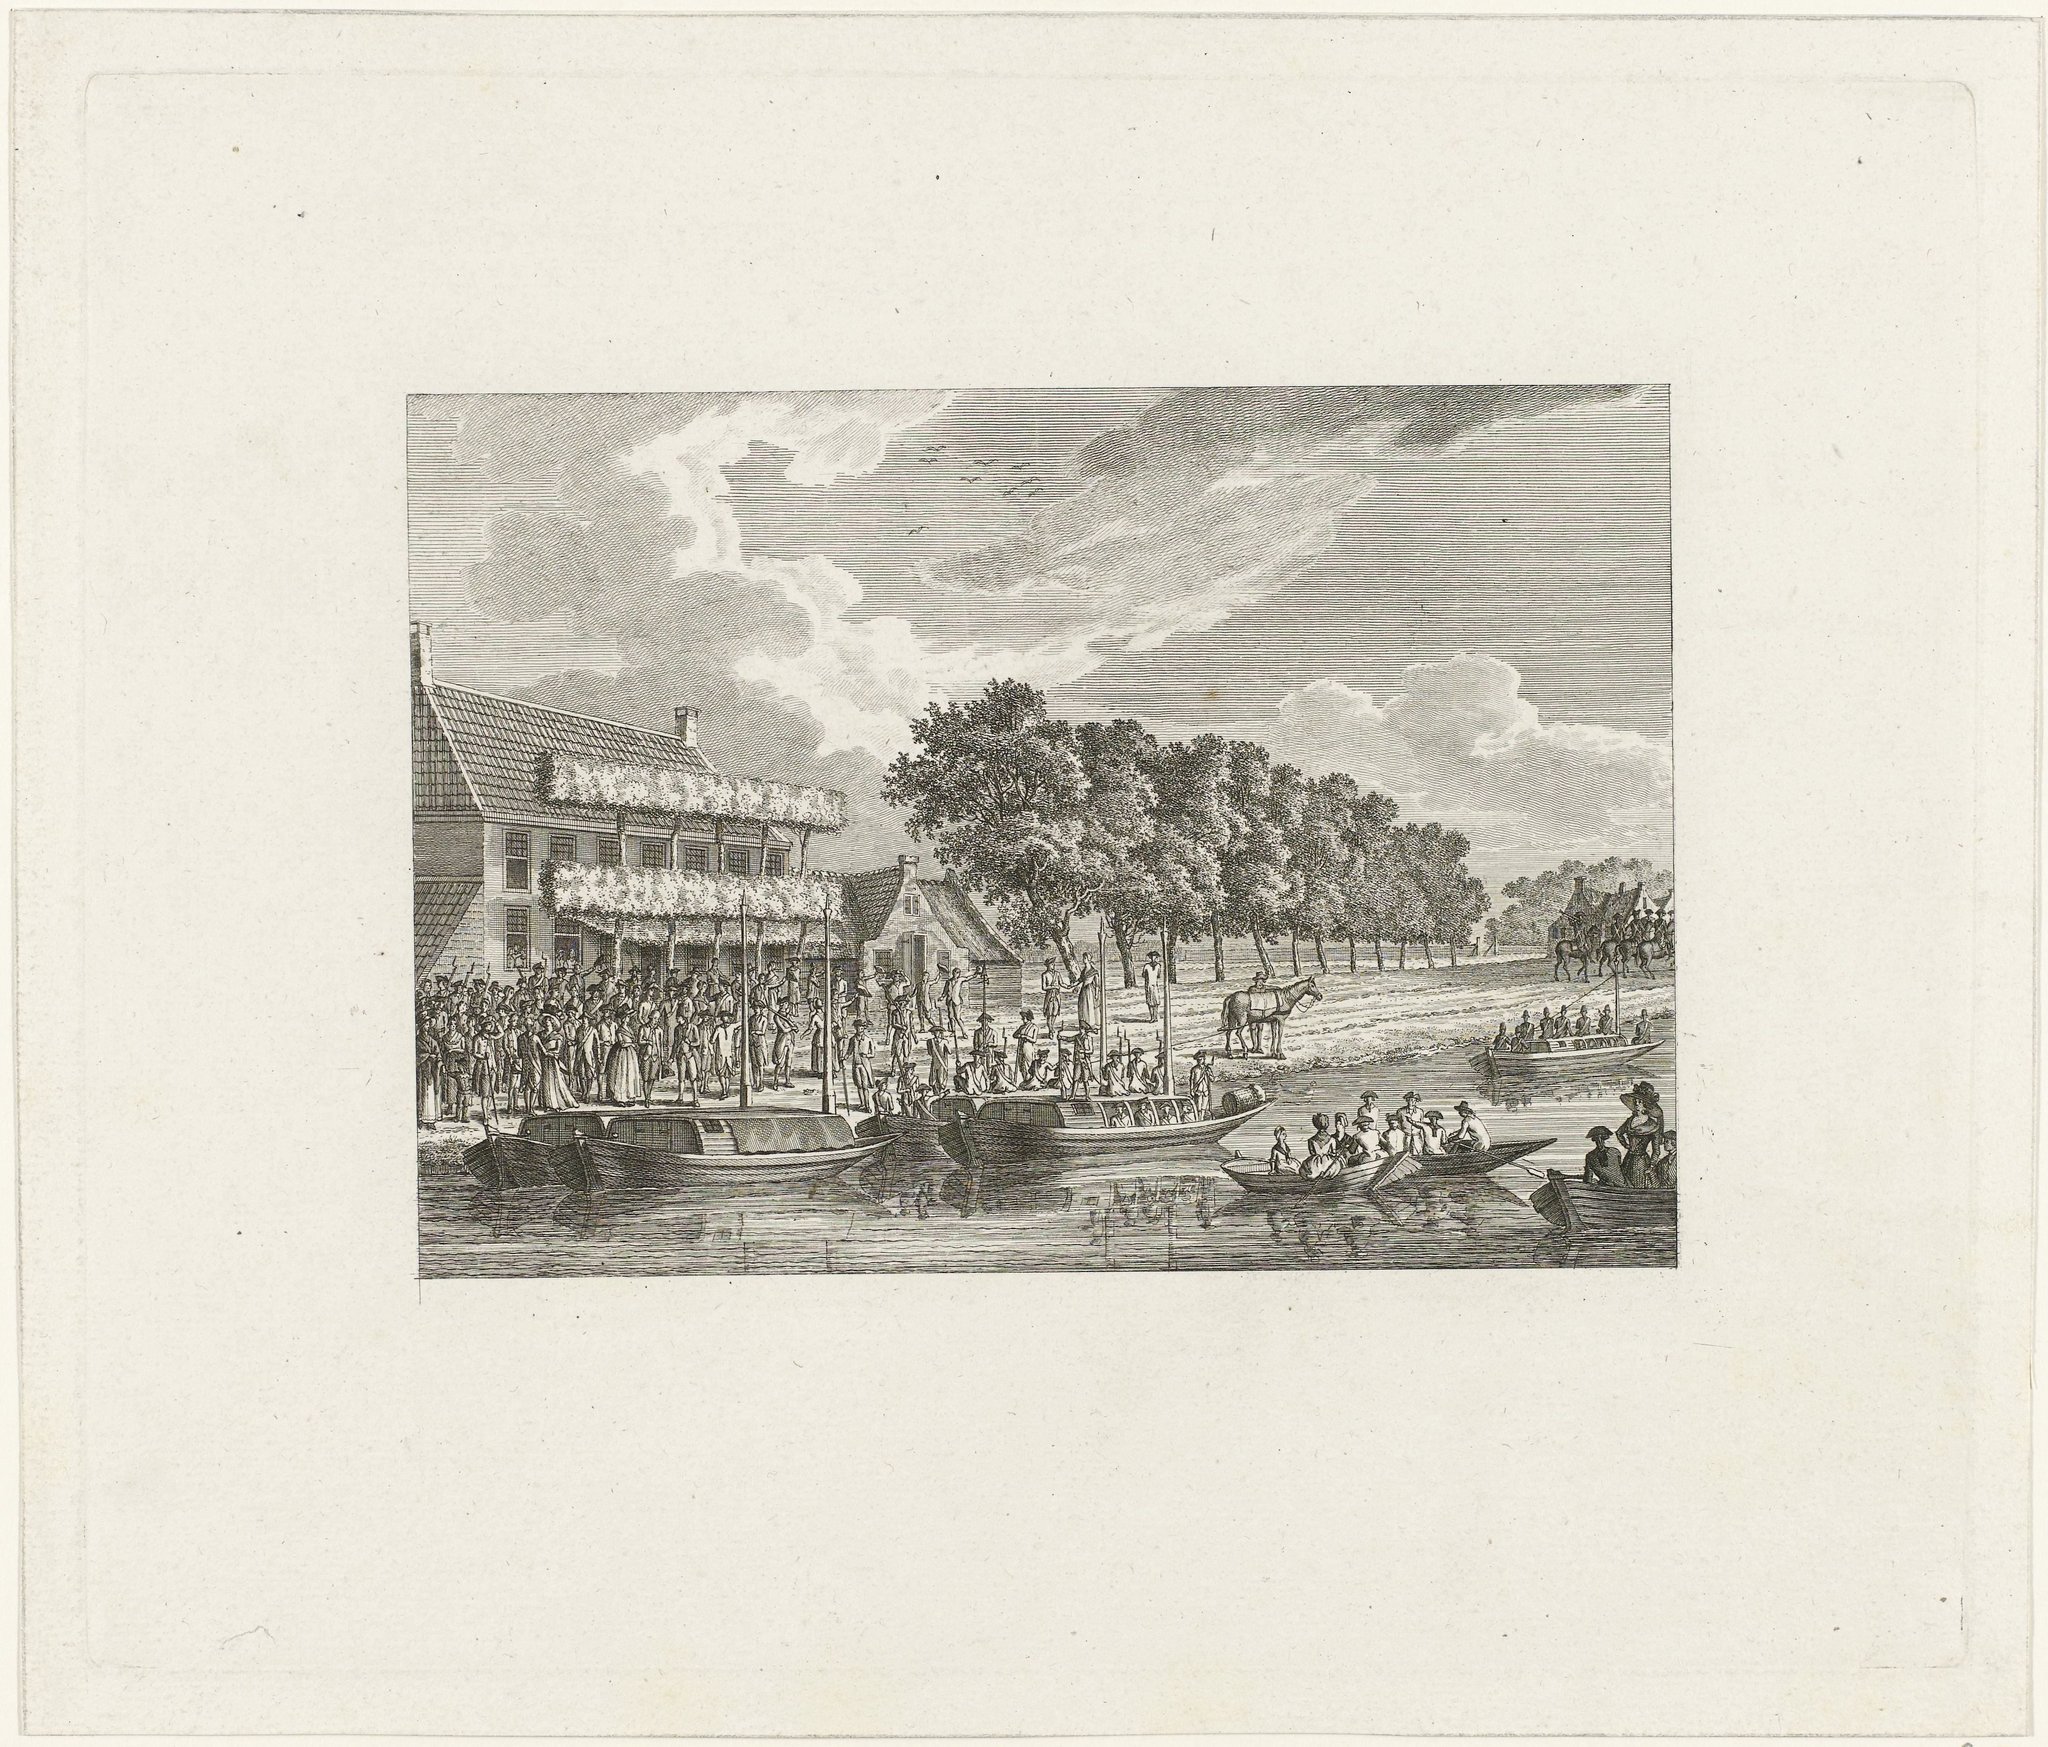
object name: print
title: Gewapende Amsterdamse burgers trekken uit naar Muiden, 1787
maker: Anonymous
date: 1787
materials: paper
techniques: engraving, etching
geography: northern netherlands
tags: amsterdam, patriots (1780-1795)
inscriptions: collector's mark: Lugt 2228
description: Vertrek van de gewapende Amsterdamse burgers vanuit de uitspanning Lokhorst aan de Weesperzijde in schuiten naar Muiden, 7 juni 1787. De prent heeft een pendant.